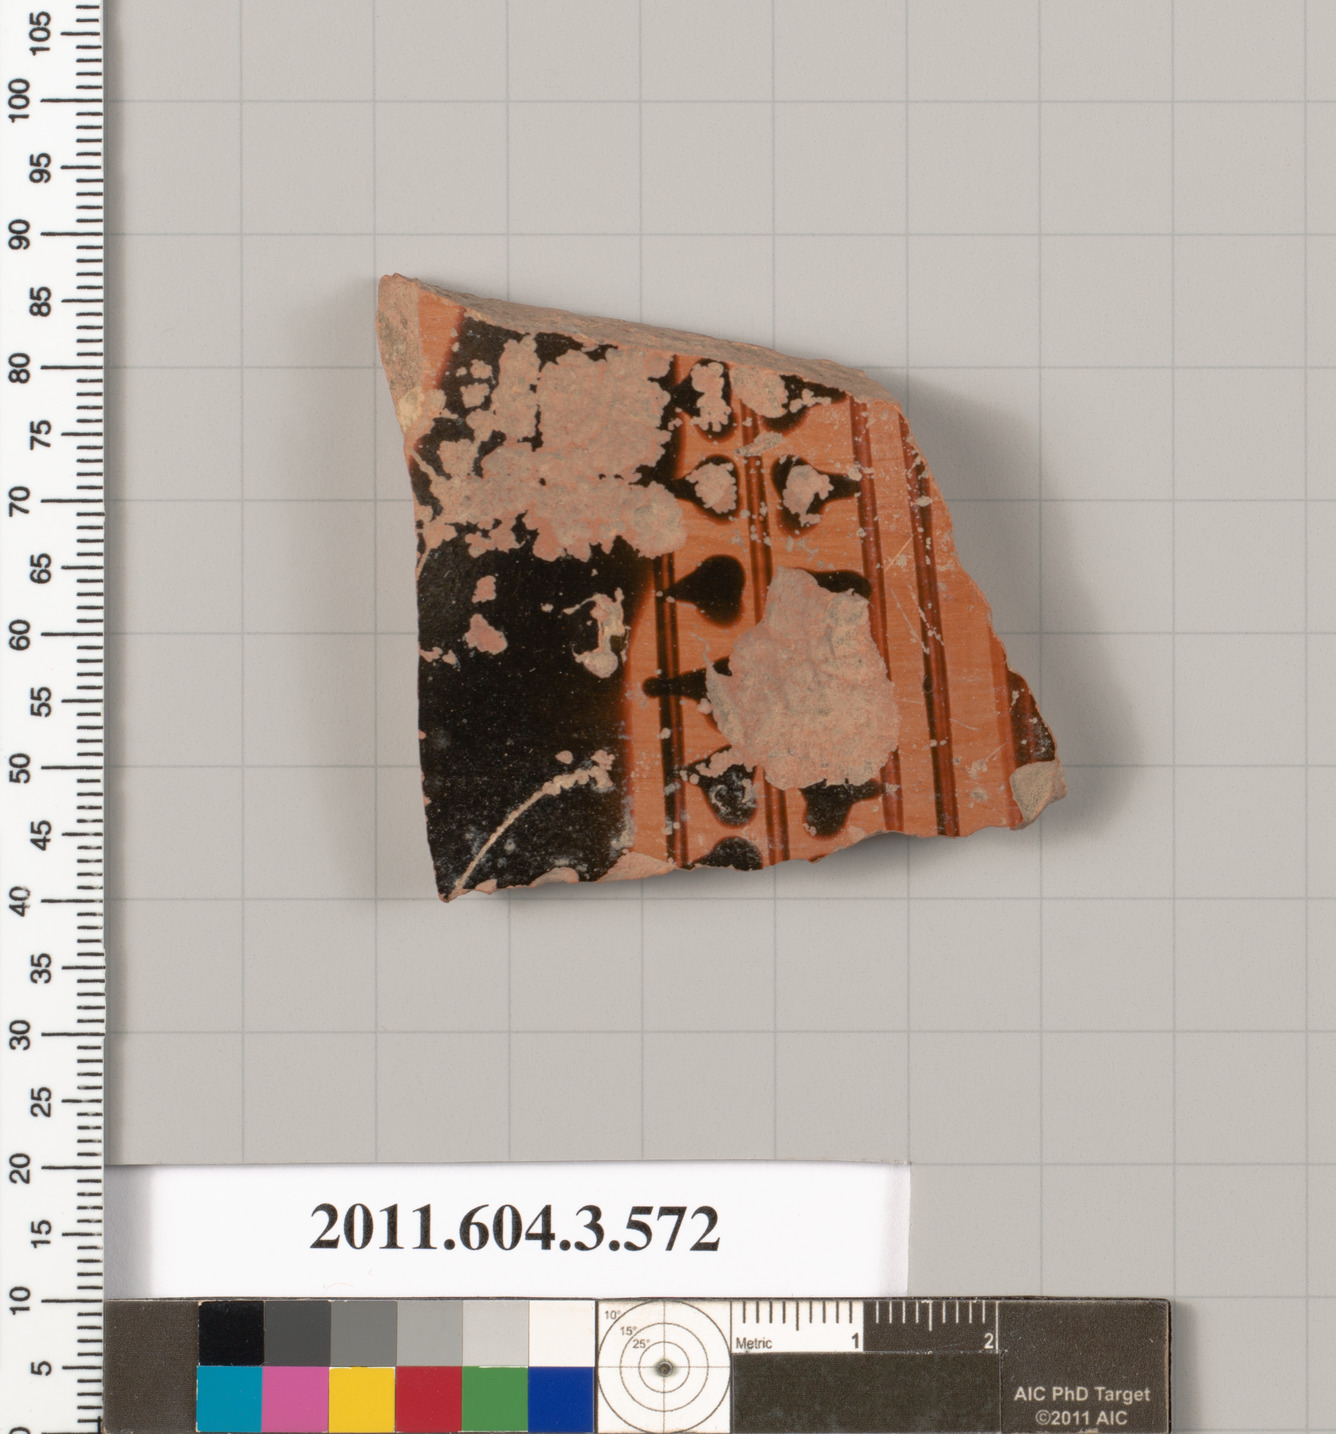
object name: column krater fragment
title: Terracotta fragment of a column-krater (bowl for mixing wine and water)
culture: greek, attic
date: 534-468 BCE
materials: terracotta